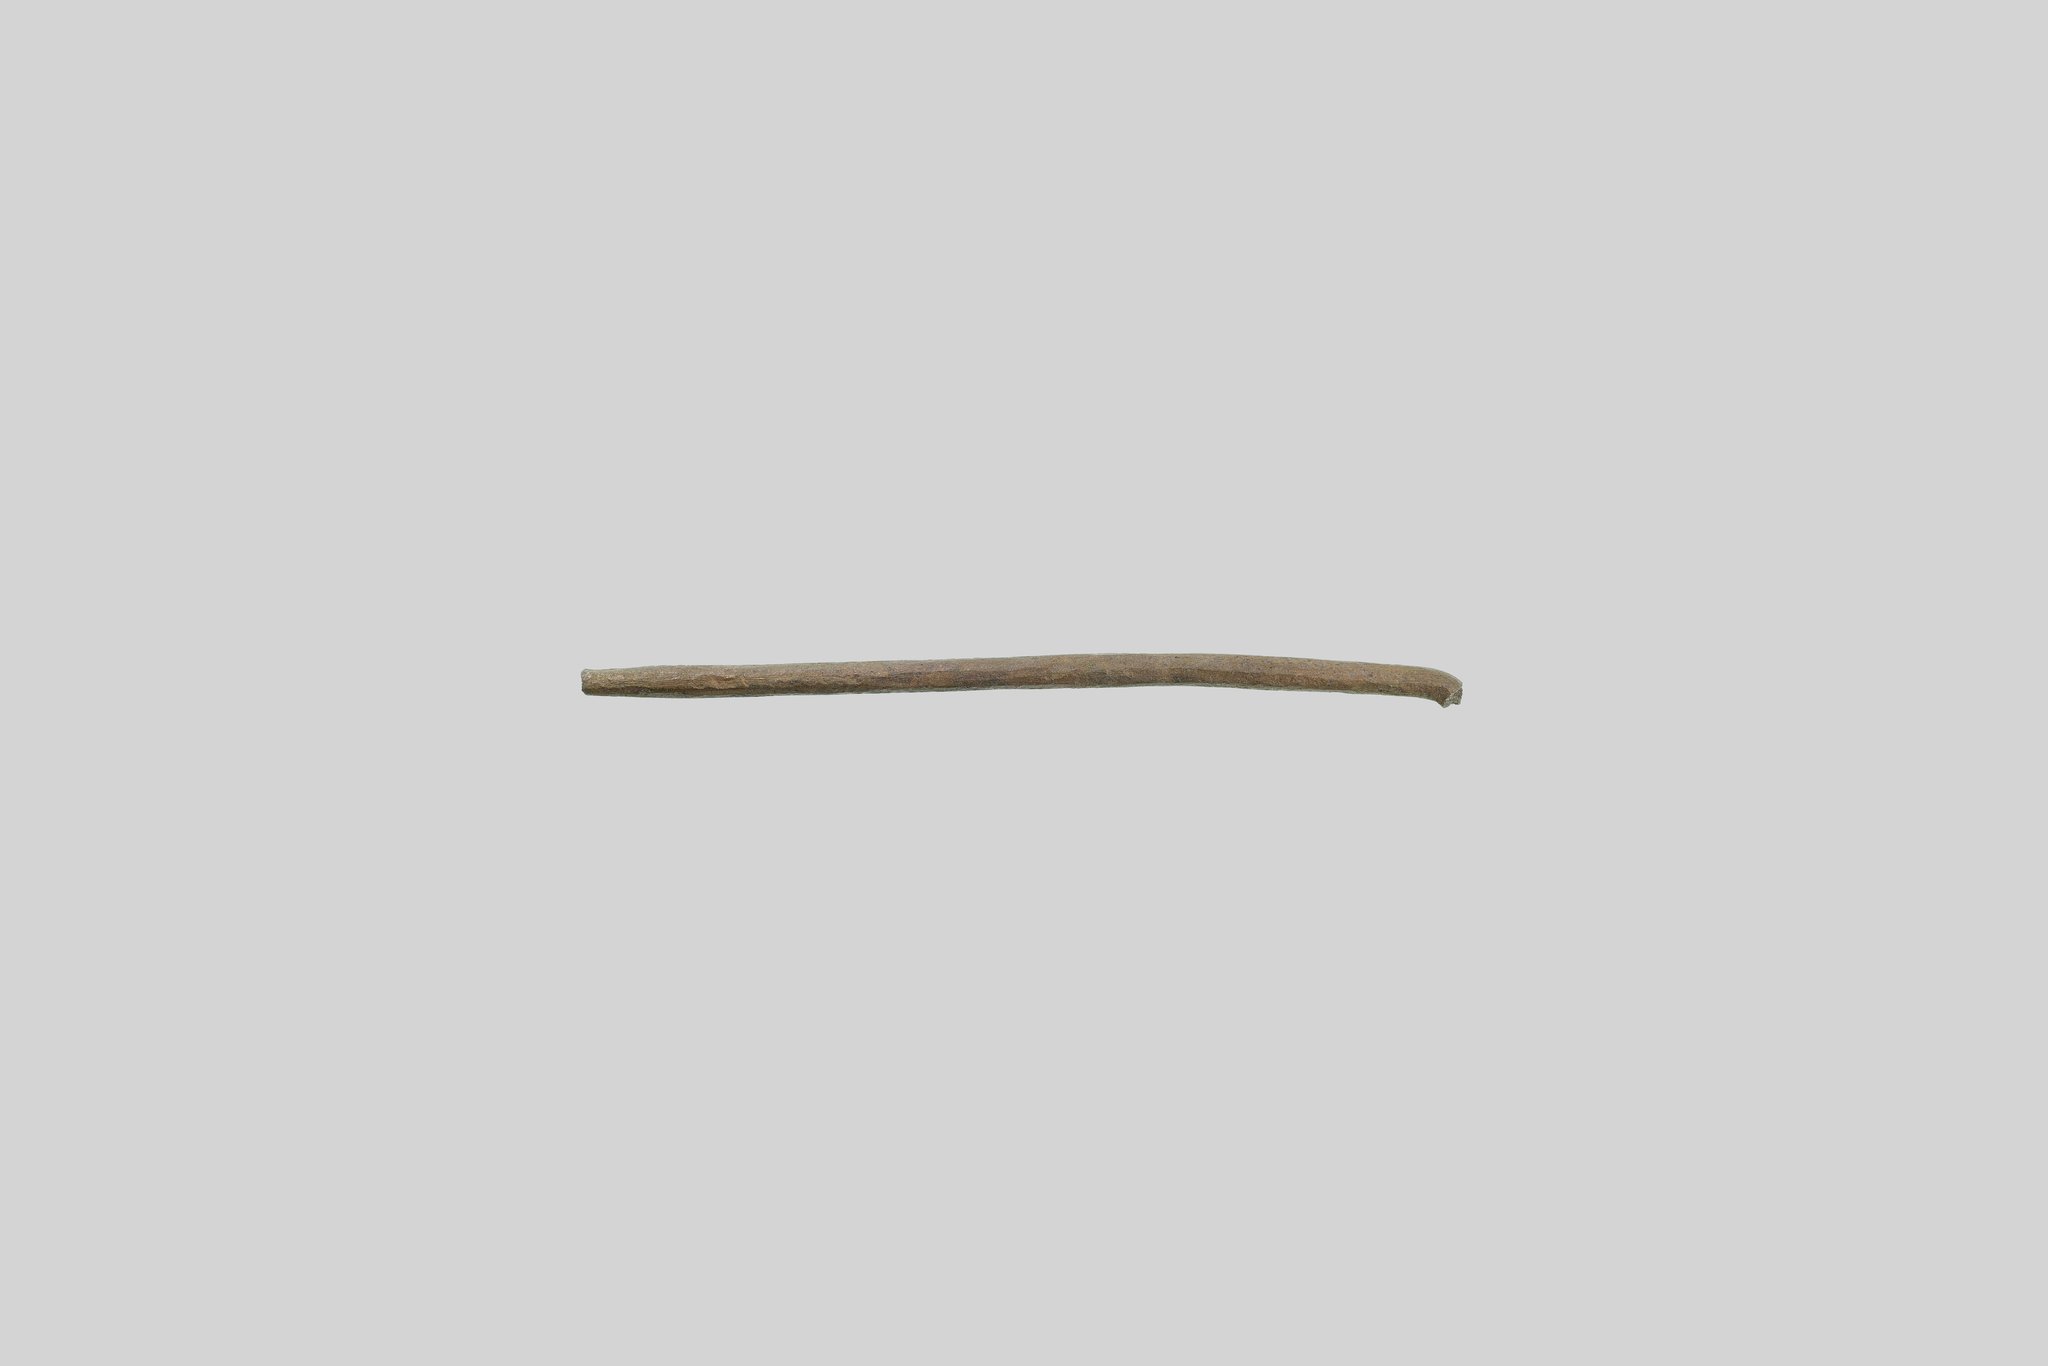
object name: rod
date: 664-332 BCE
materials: copper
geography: egypt